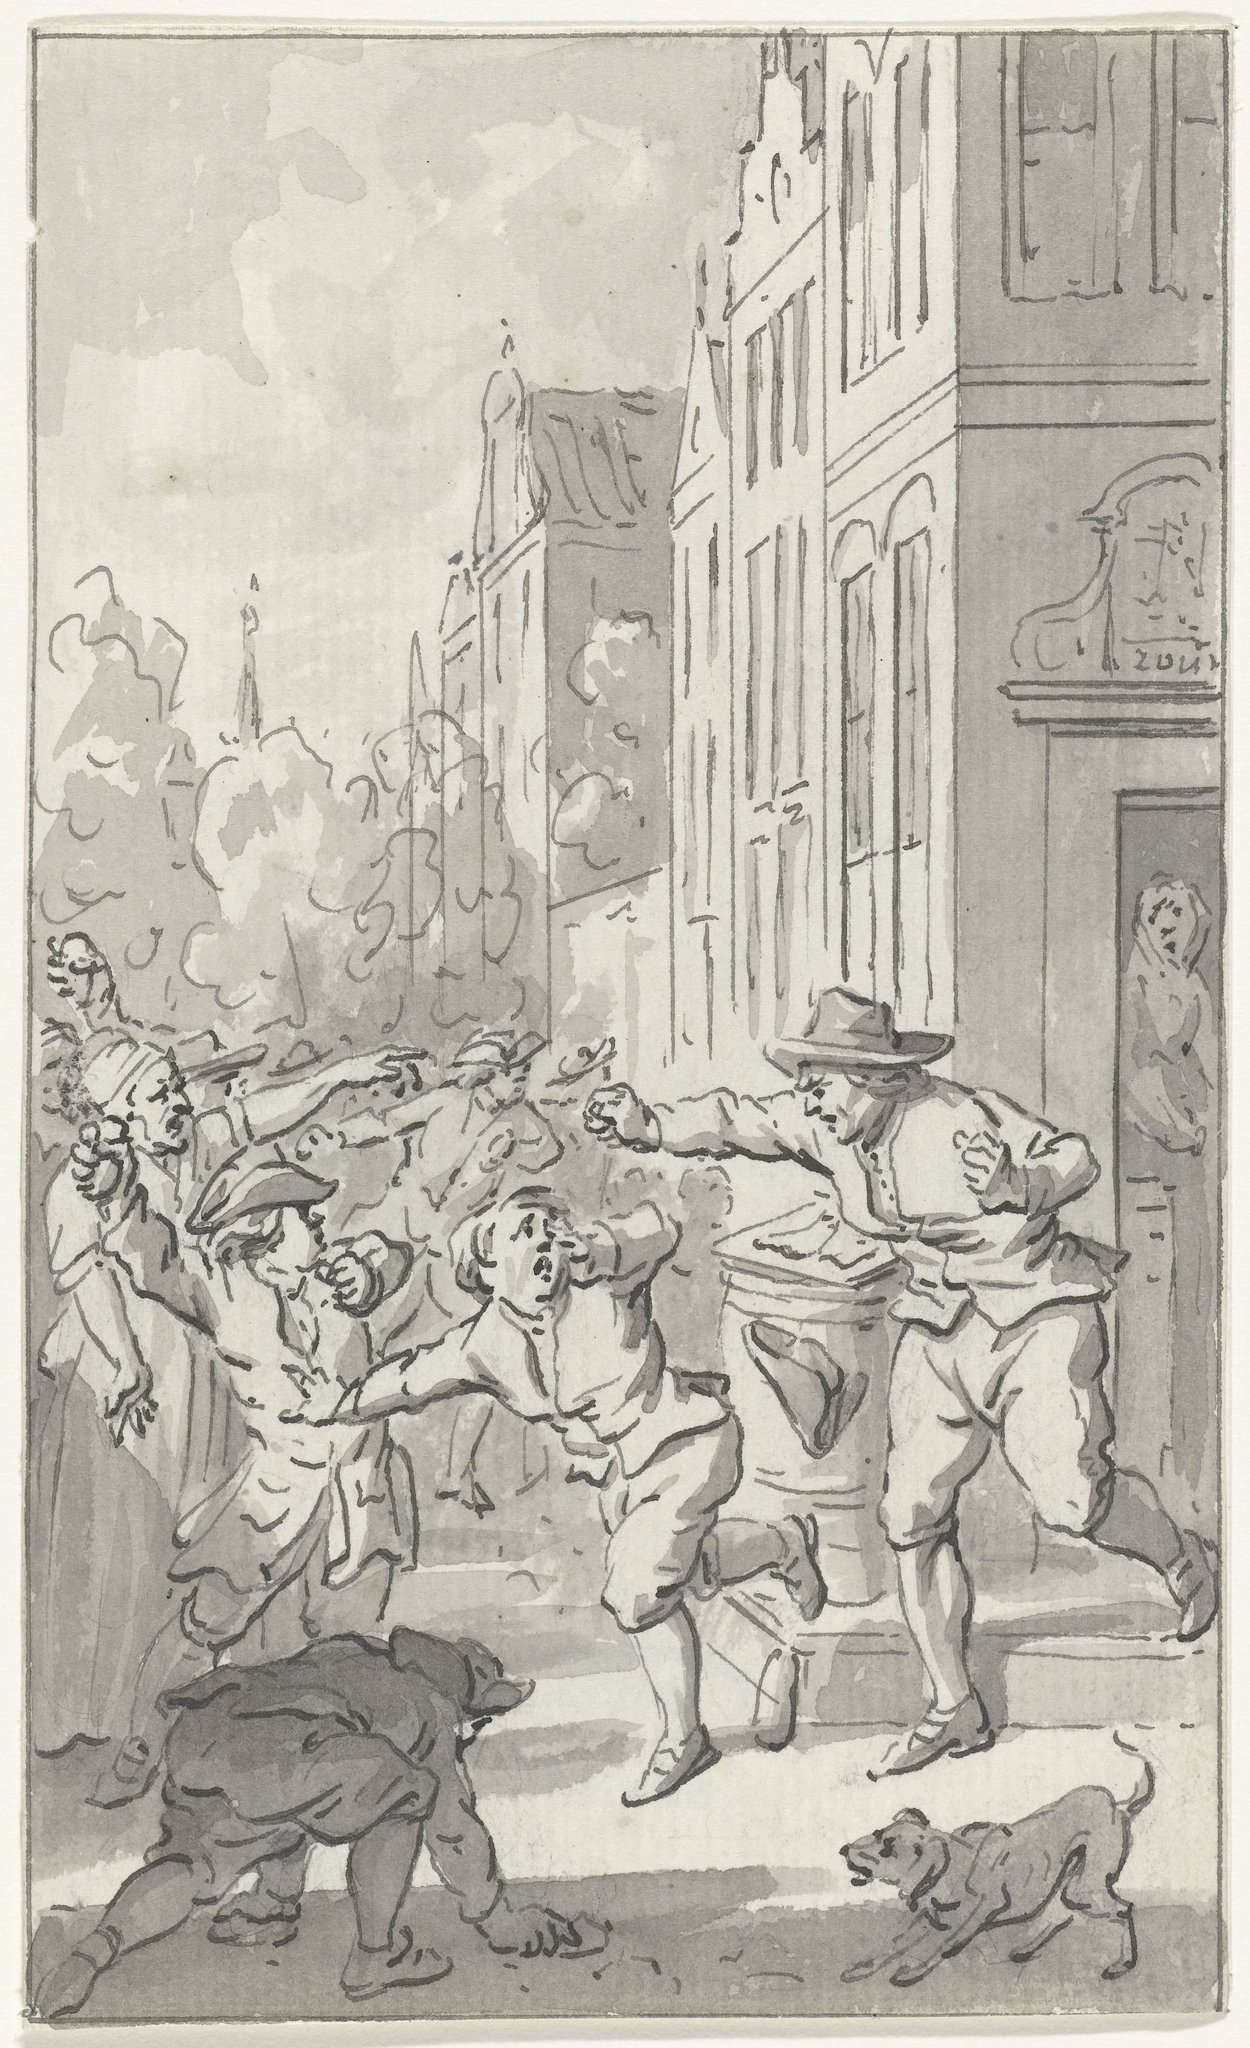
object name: drawing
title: Plundering van het huis van een Fransgezinde visverkoper te Deventer, 1747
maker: jacobus buys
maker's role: draughtsman, print maker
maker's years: 1724-1801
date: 1788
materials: paper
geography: northern netherlands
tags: plundering ~ riot, deventer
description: Niet in Frederik Muller; door het RPK toegevoegd nummer. Ontwerptekening voor de prent FMH 3918a uit 1788 getiteld "Een vischverkoper te Deventer, in 't jaar 1747, door 't gemeen, met steenen geworpen, en zijn huis geplonderd", van Reinier Vinkeles.